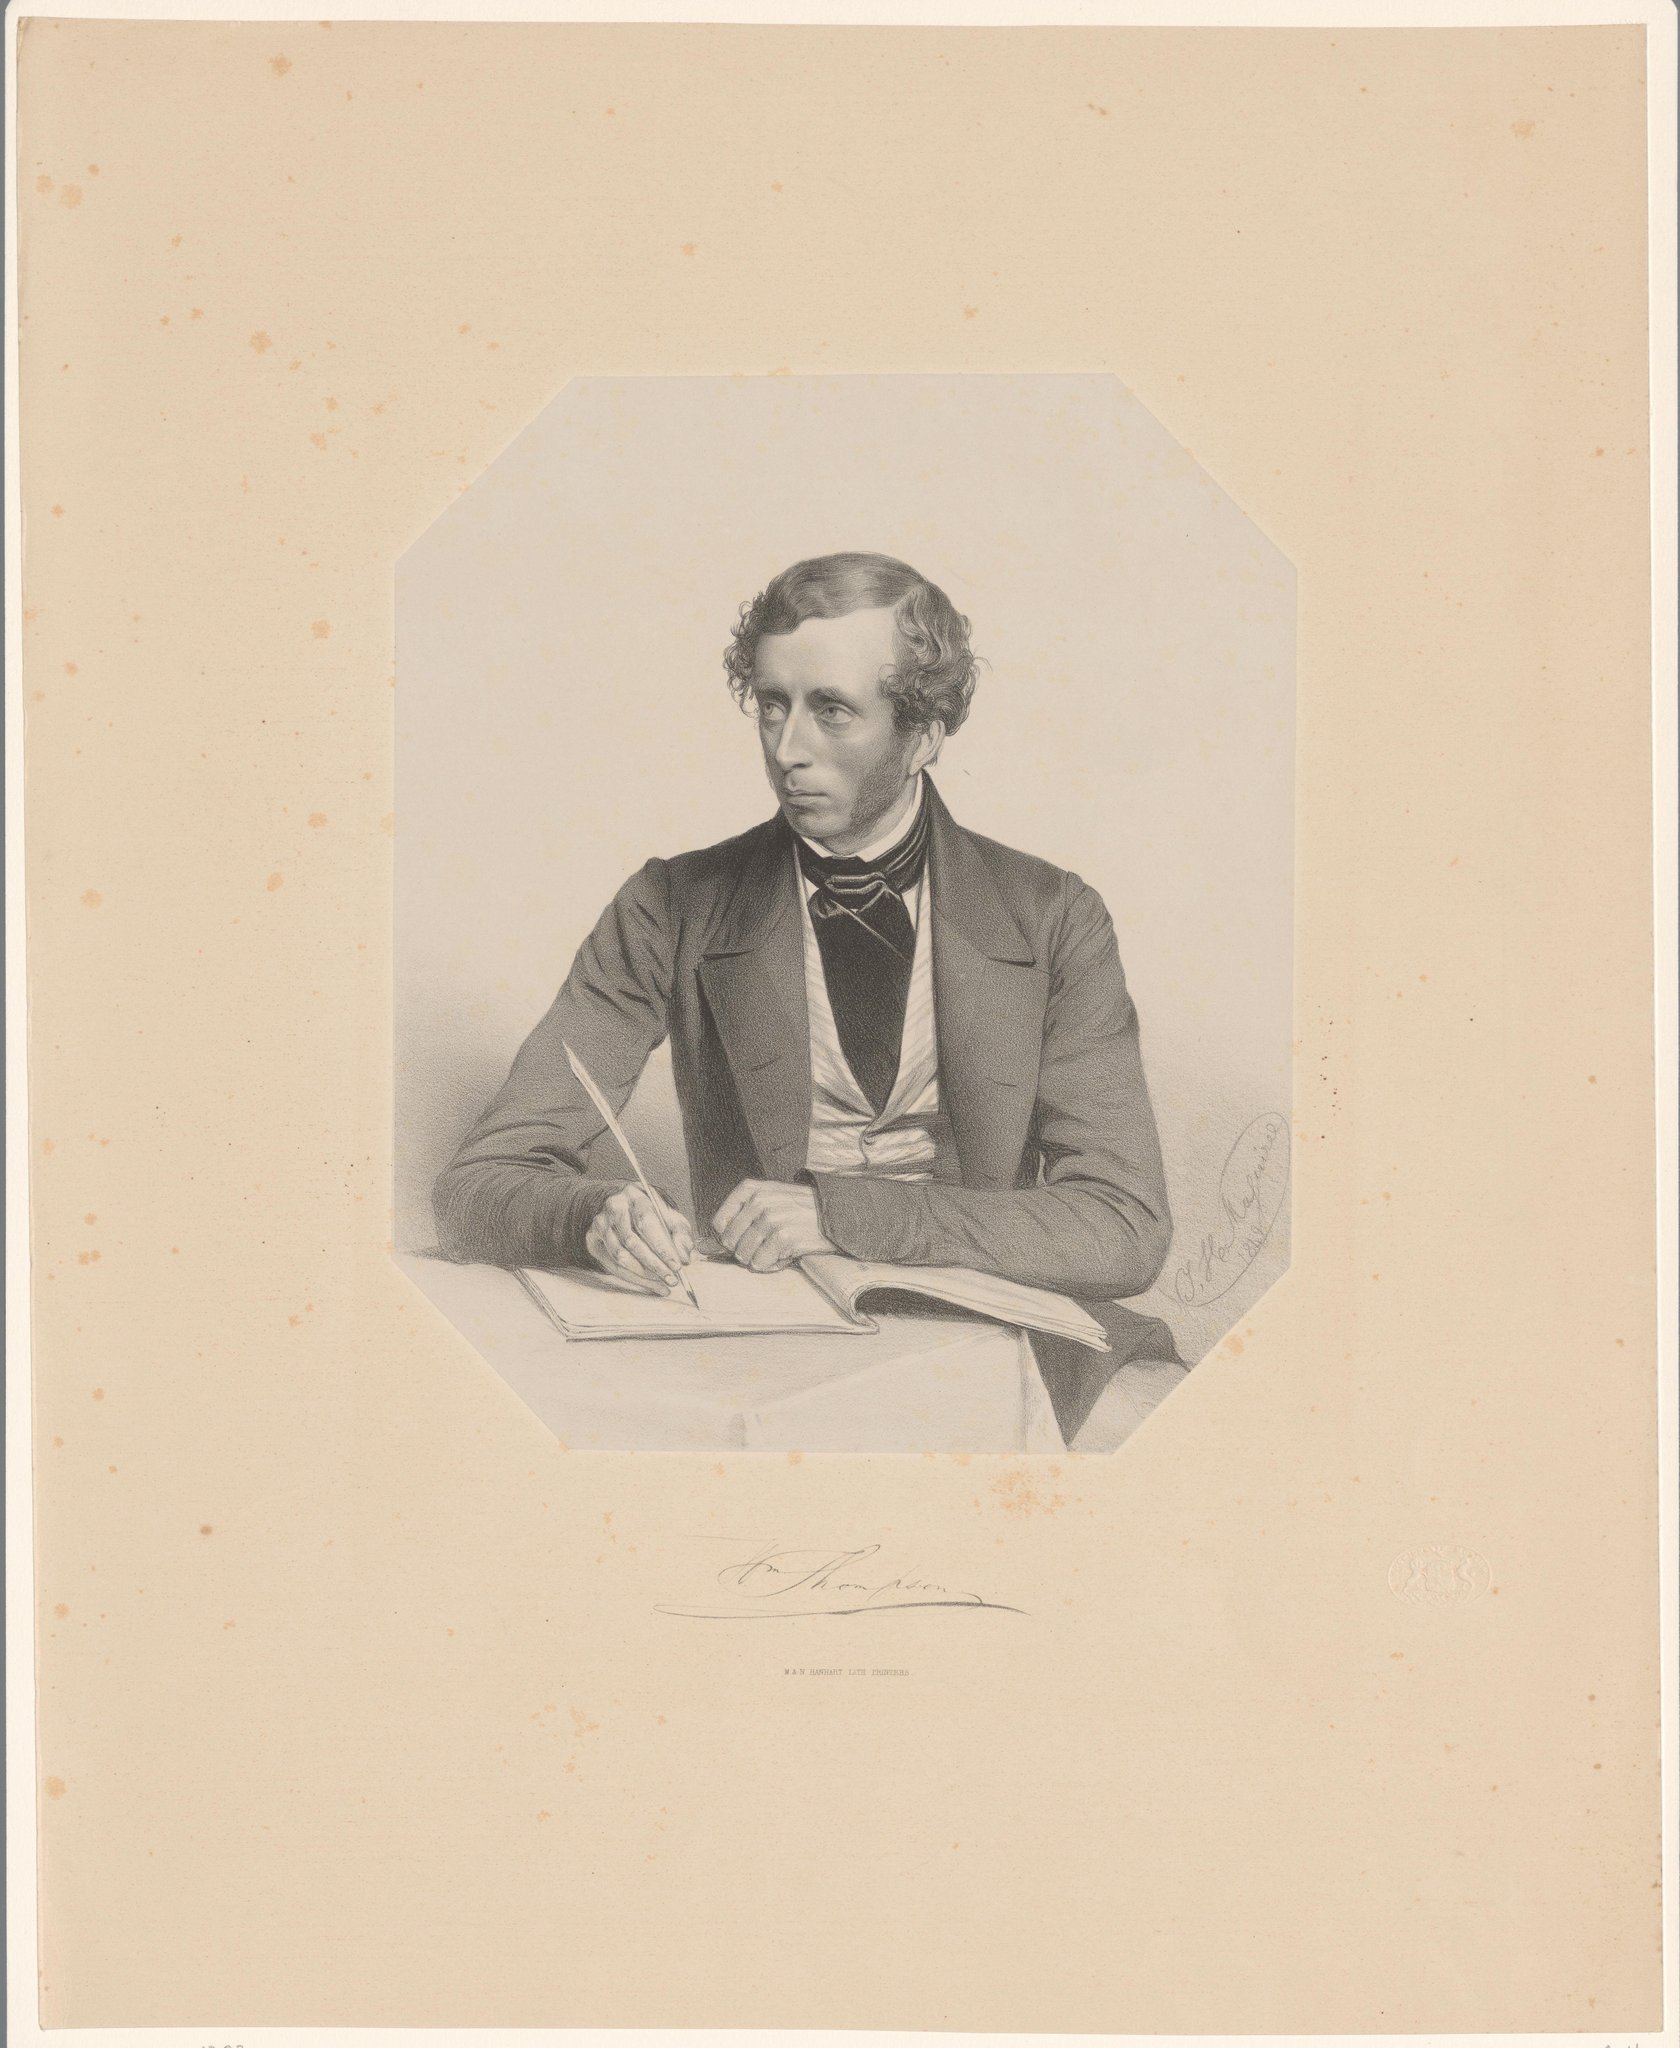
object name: print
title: Portretten uit het Ipswich Museum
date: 1852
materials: paper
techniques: lithograph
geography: london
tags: writing tools, adult man, historical persons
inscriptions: check stamp: ‘Ipswich Museum’, collector's mark: Lugt 2228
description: Prent behoort tot de serie 'Ipswich Museum Portraits', ook bekend onder de titel 'Portraits of Honorary Members of the Ipswich Museum'. Deze serie is in 1852 door George Ransome uitgegeven en gedrukt door M&N Hanhart tussen 1848 en 1852. De serie bestaat uit ca. 60 portretten.